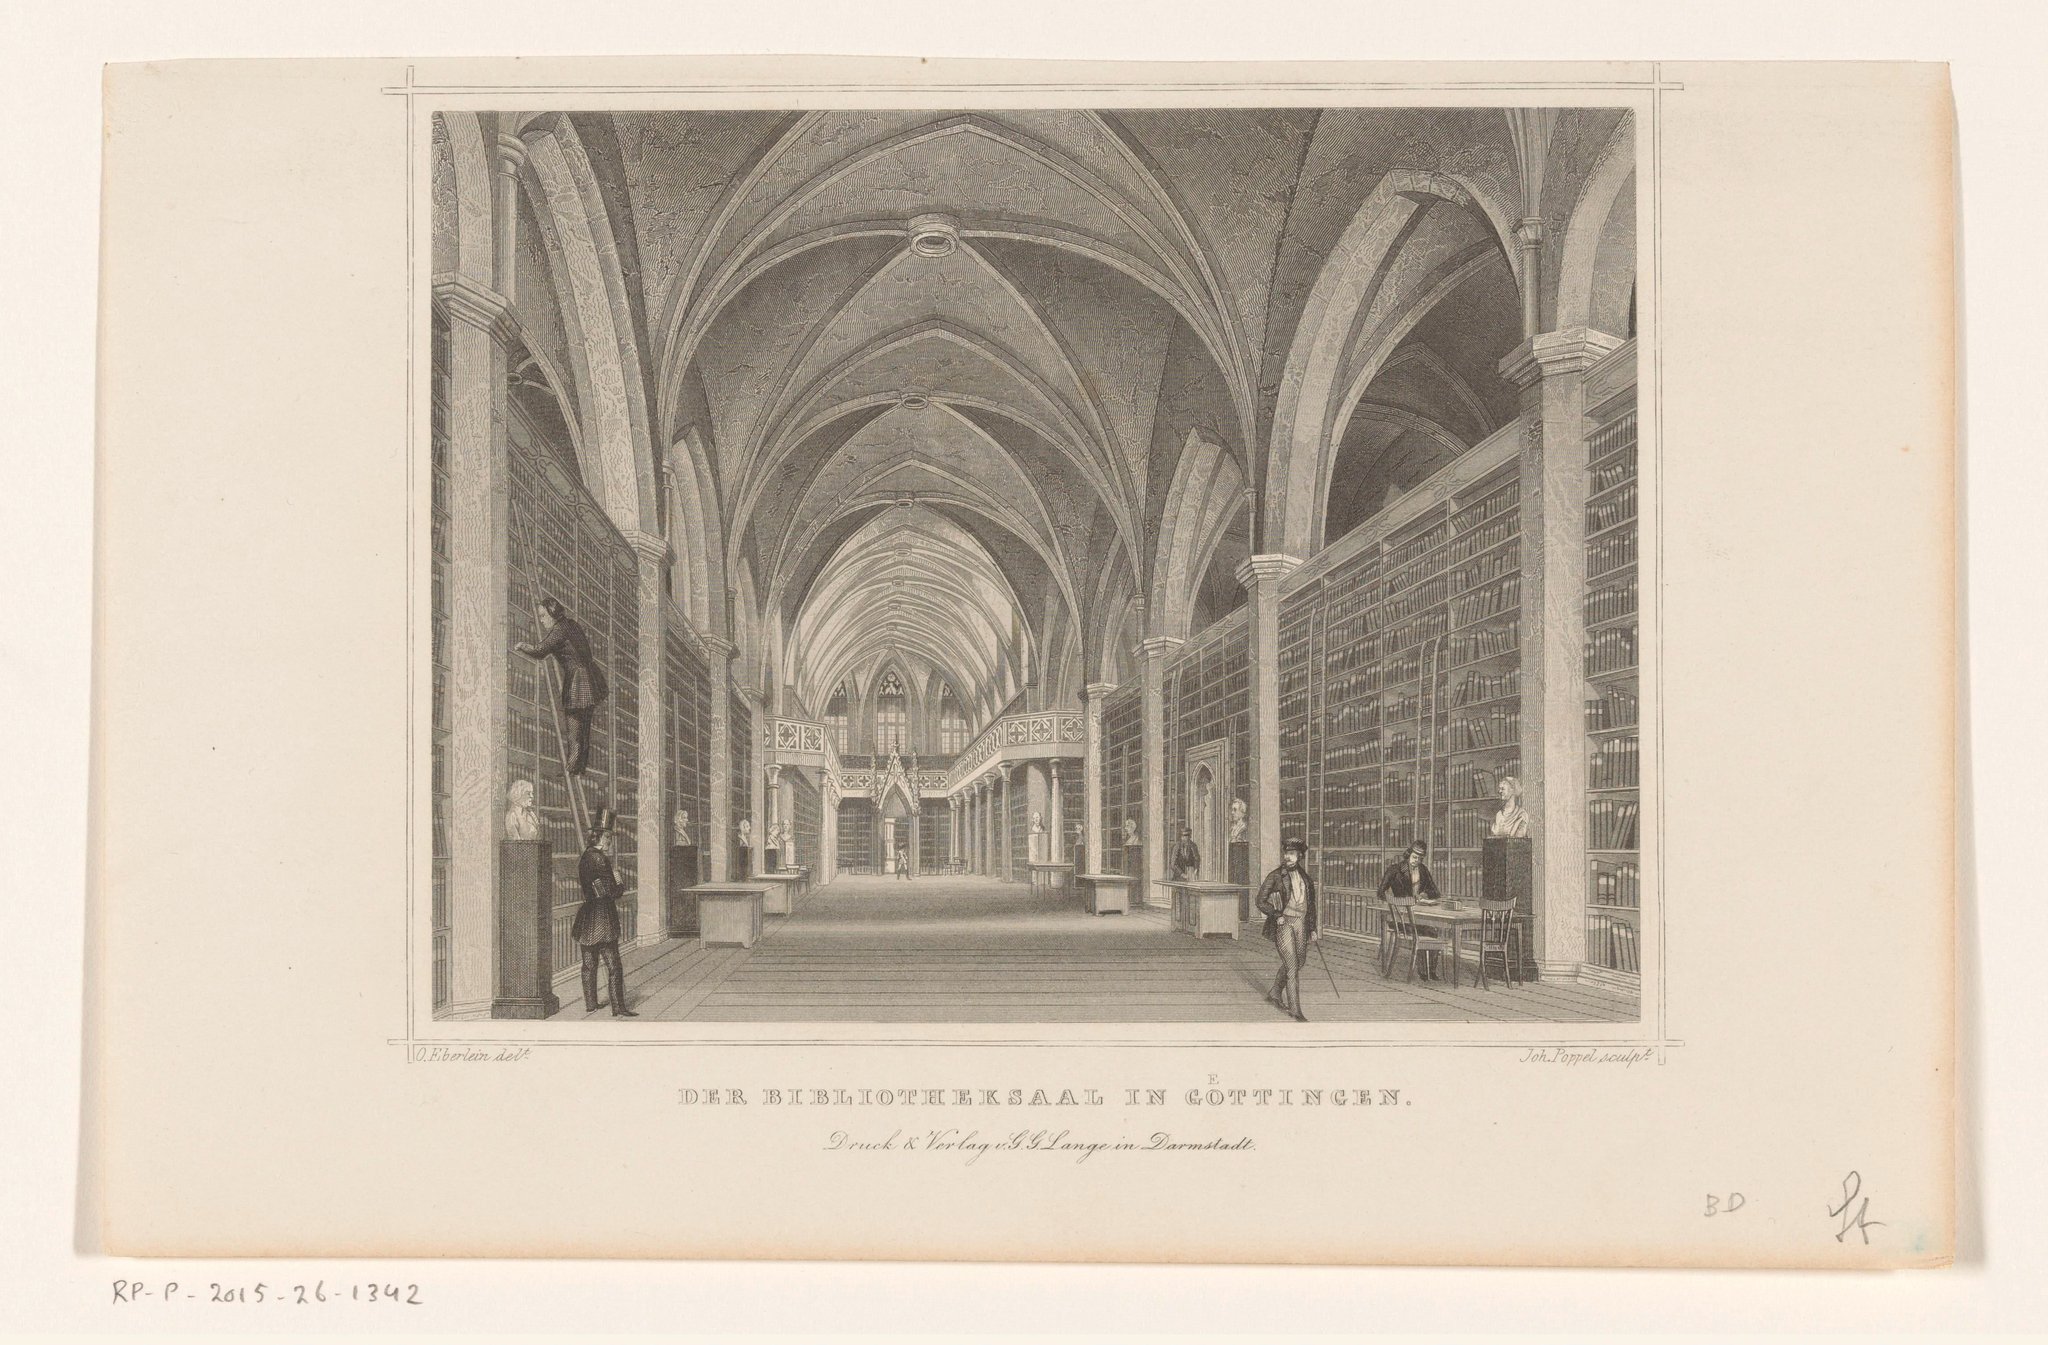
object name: book illustration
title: Bibliotheek van Göttingen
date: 1832-1852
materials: paper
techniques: engraving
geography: darmstadt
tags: paulinerkirche, universiteit van göttingen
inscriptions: collector's mark: Lugt 4780, collector's mark: Lugt 4779, collector's mark: Lugt 2228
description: Prent afkomstig uit: Original-Ansichten der vornehmsten Städte in Deutschland. Darmstadt: Gustav Georg Lange, 1832-1852.